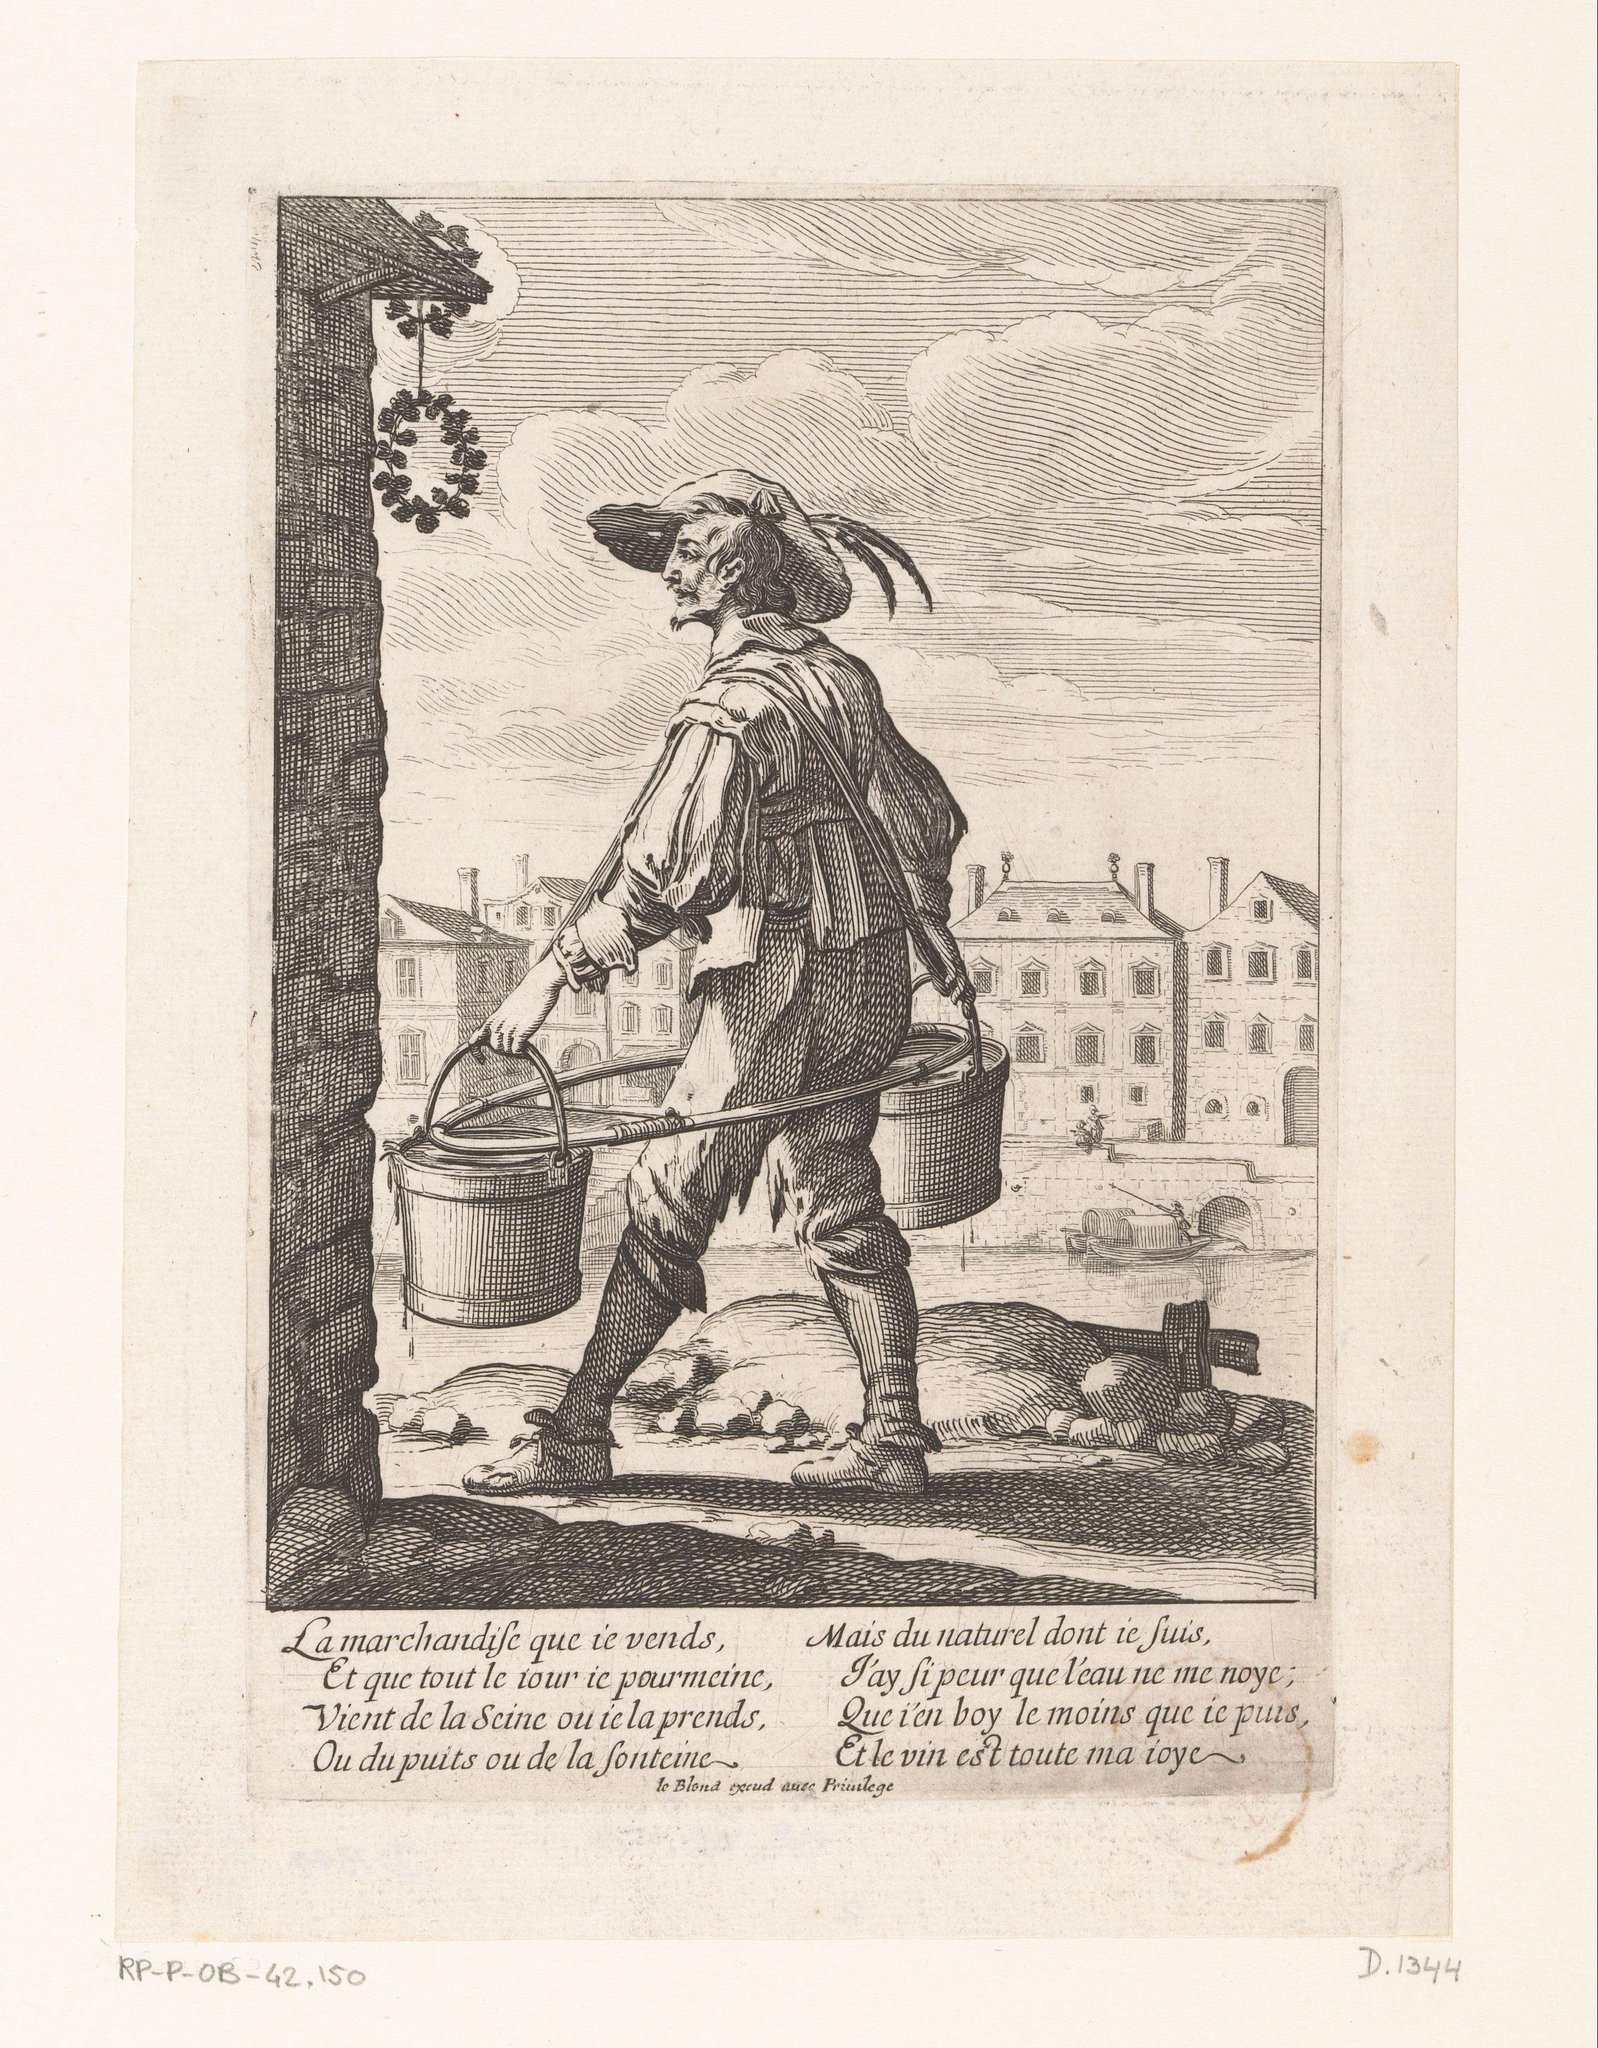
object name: print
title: Waterdrager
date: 1629-1630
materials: paper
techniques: engraving, etching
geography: paris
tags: street-trader, wandering or travelling merchant, porter, bearer, merchant, salesman, paris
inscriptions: collector's mark: Lugt 240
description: Maakt deel uit van een serie van twaalf prenten met straatverkopers en dienstverleners, uitgegeven door Jean Leblond (I) tussen 1629-1630 te Parijs.